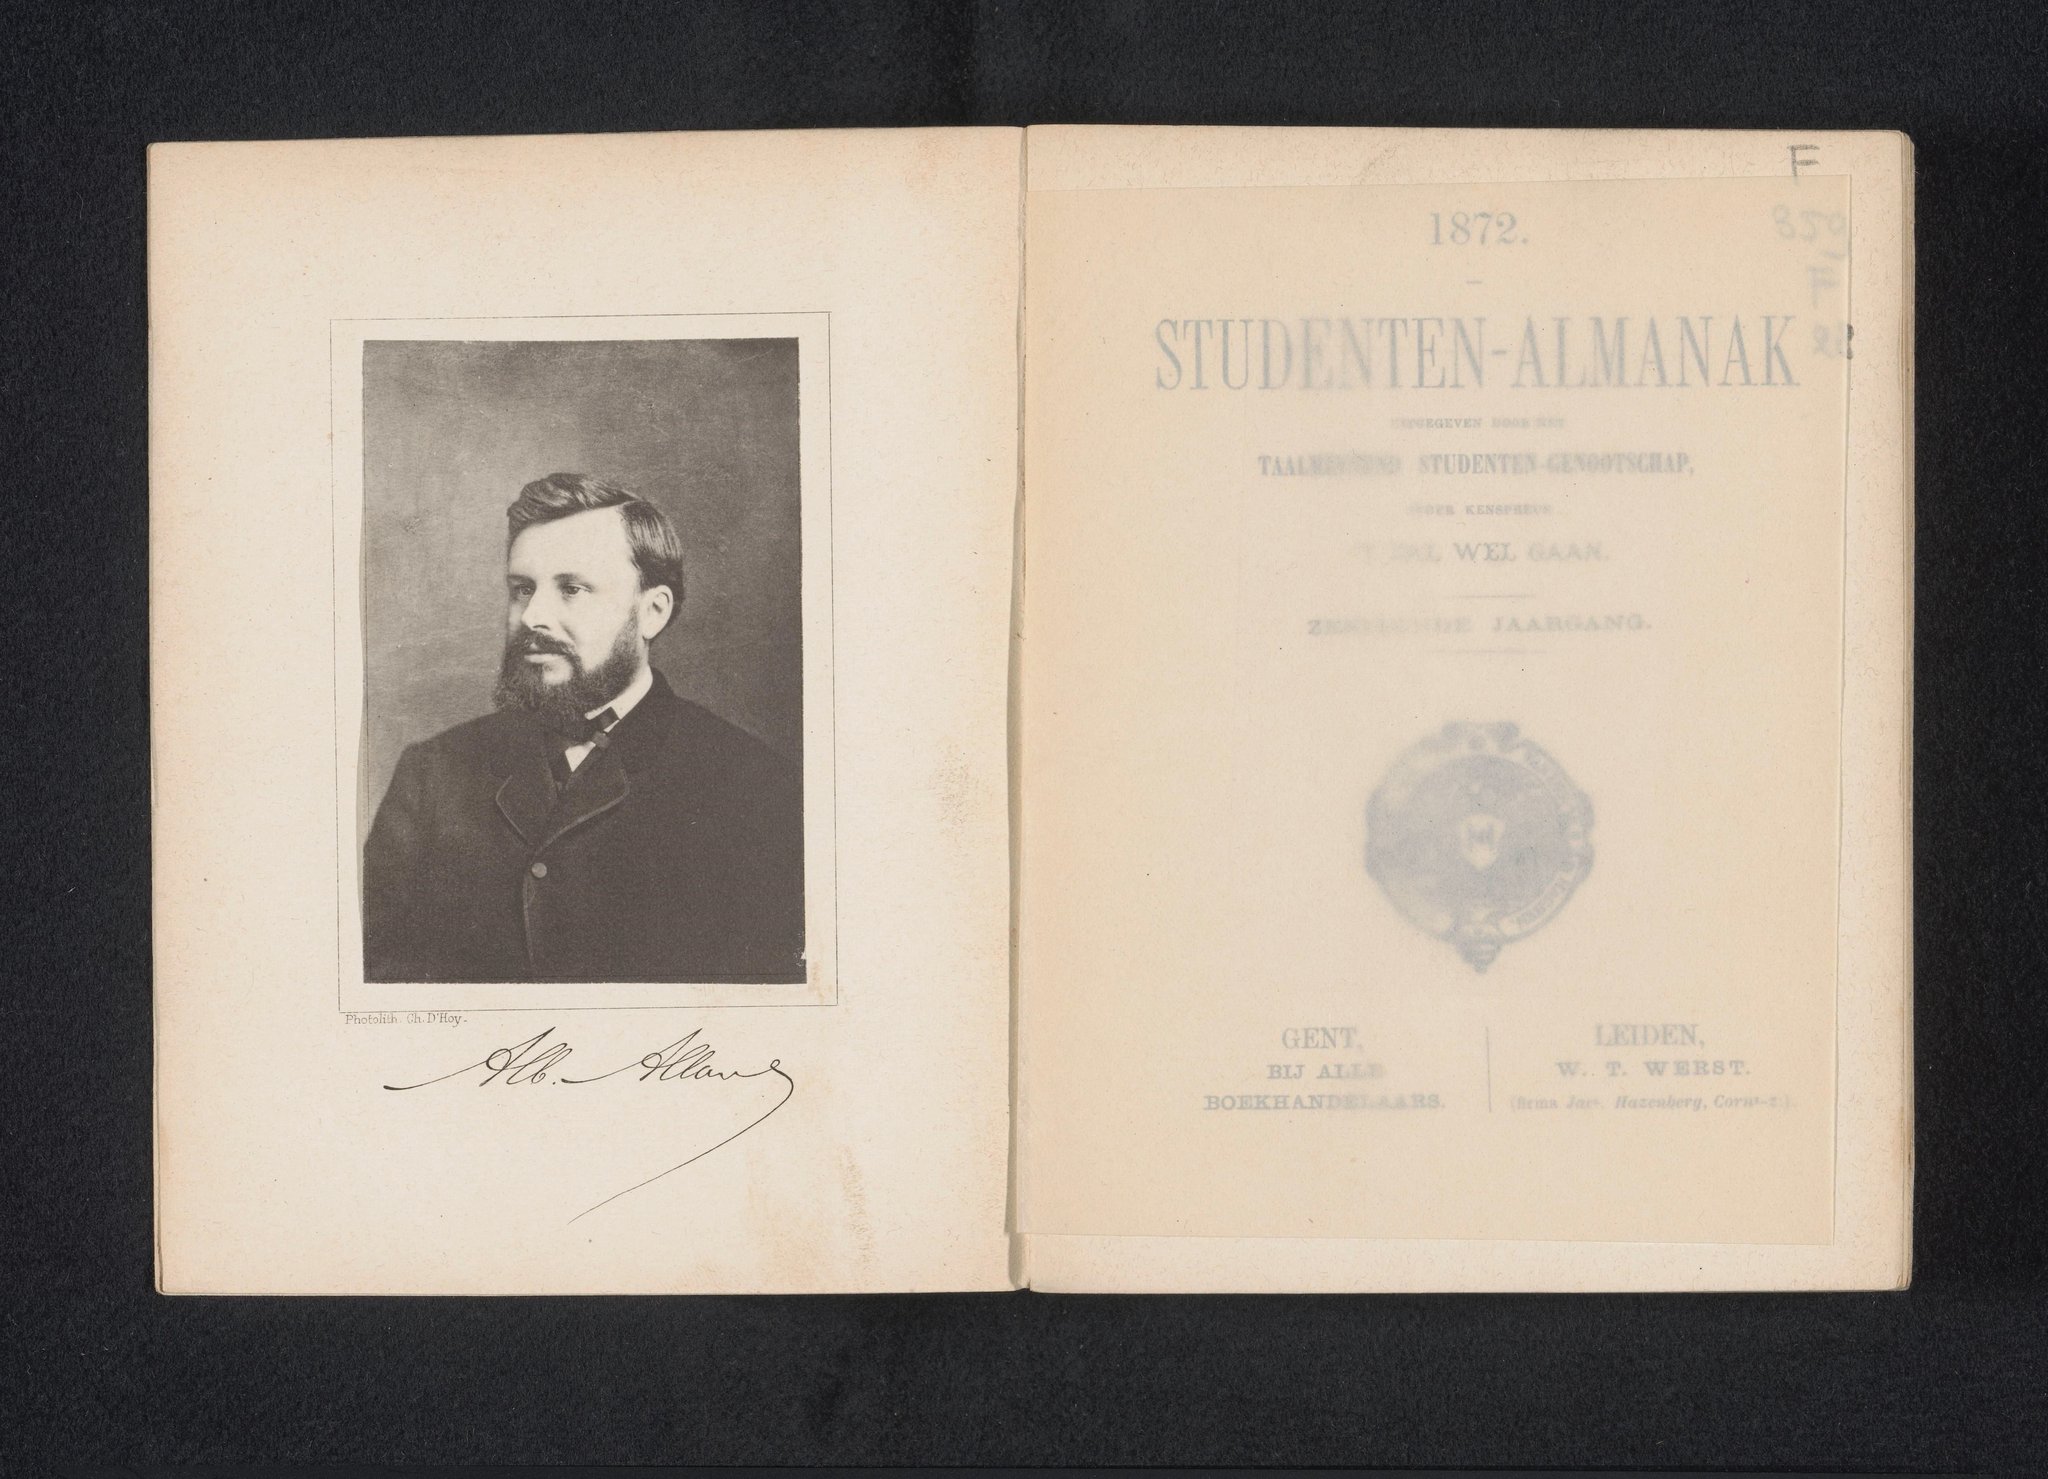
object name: photomechanical print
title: Portret van een onbekende man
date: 1872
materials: paper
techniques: photograph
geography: ghent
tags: historical persons